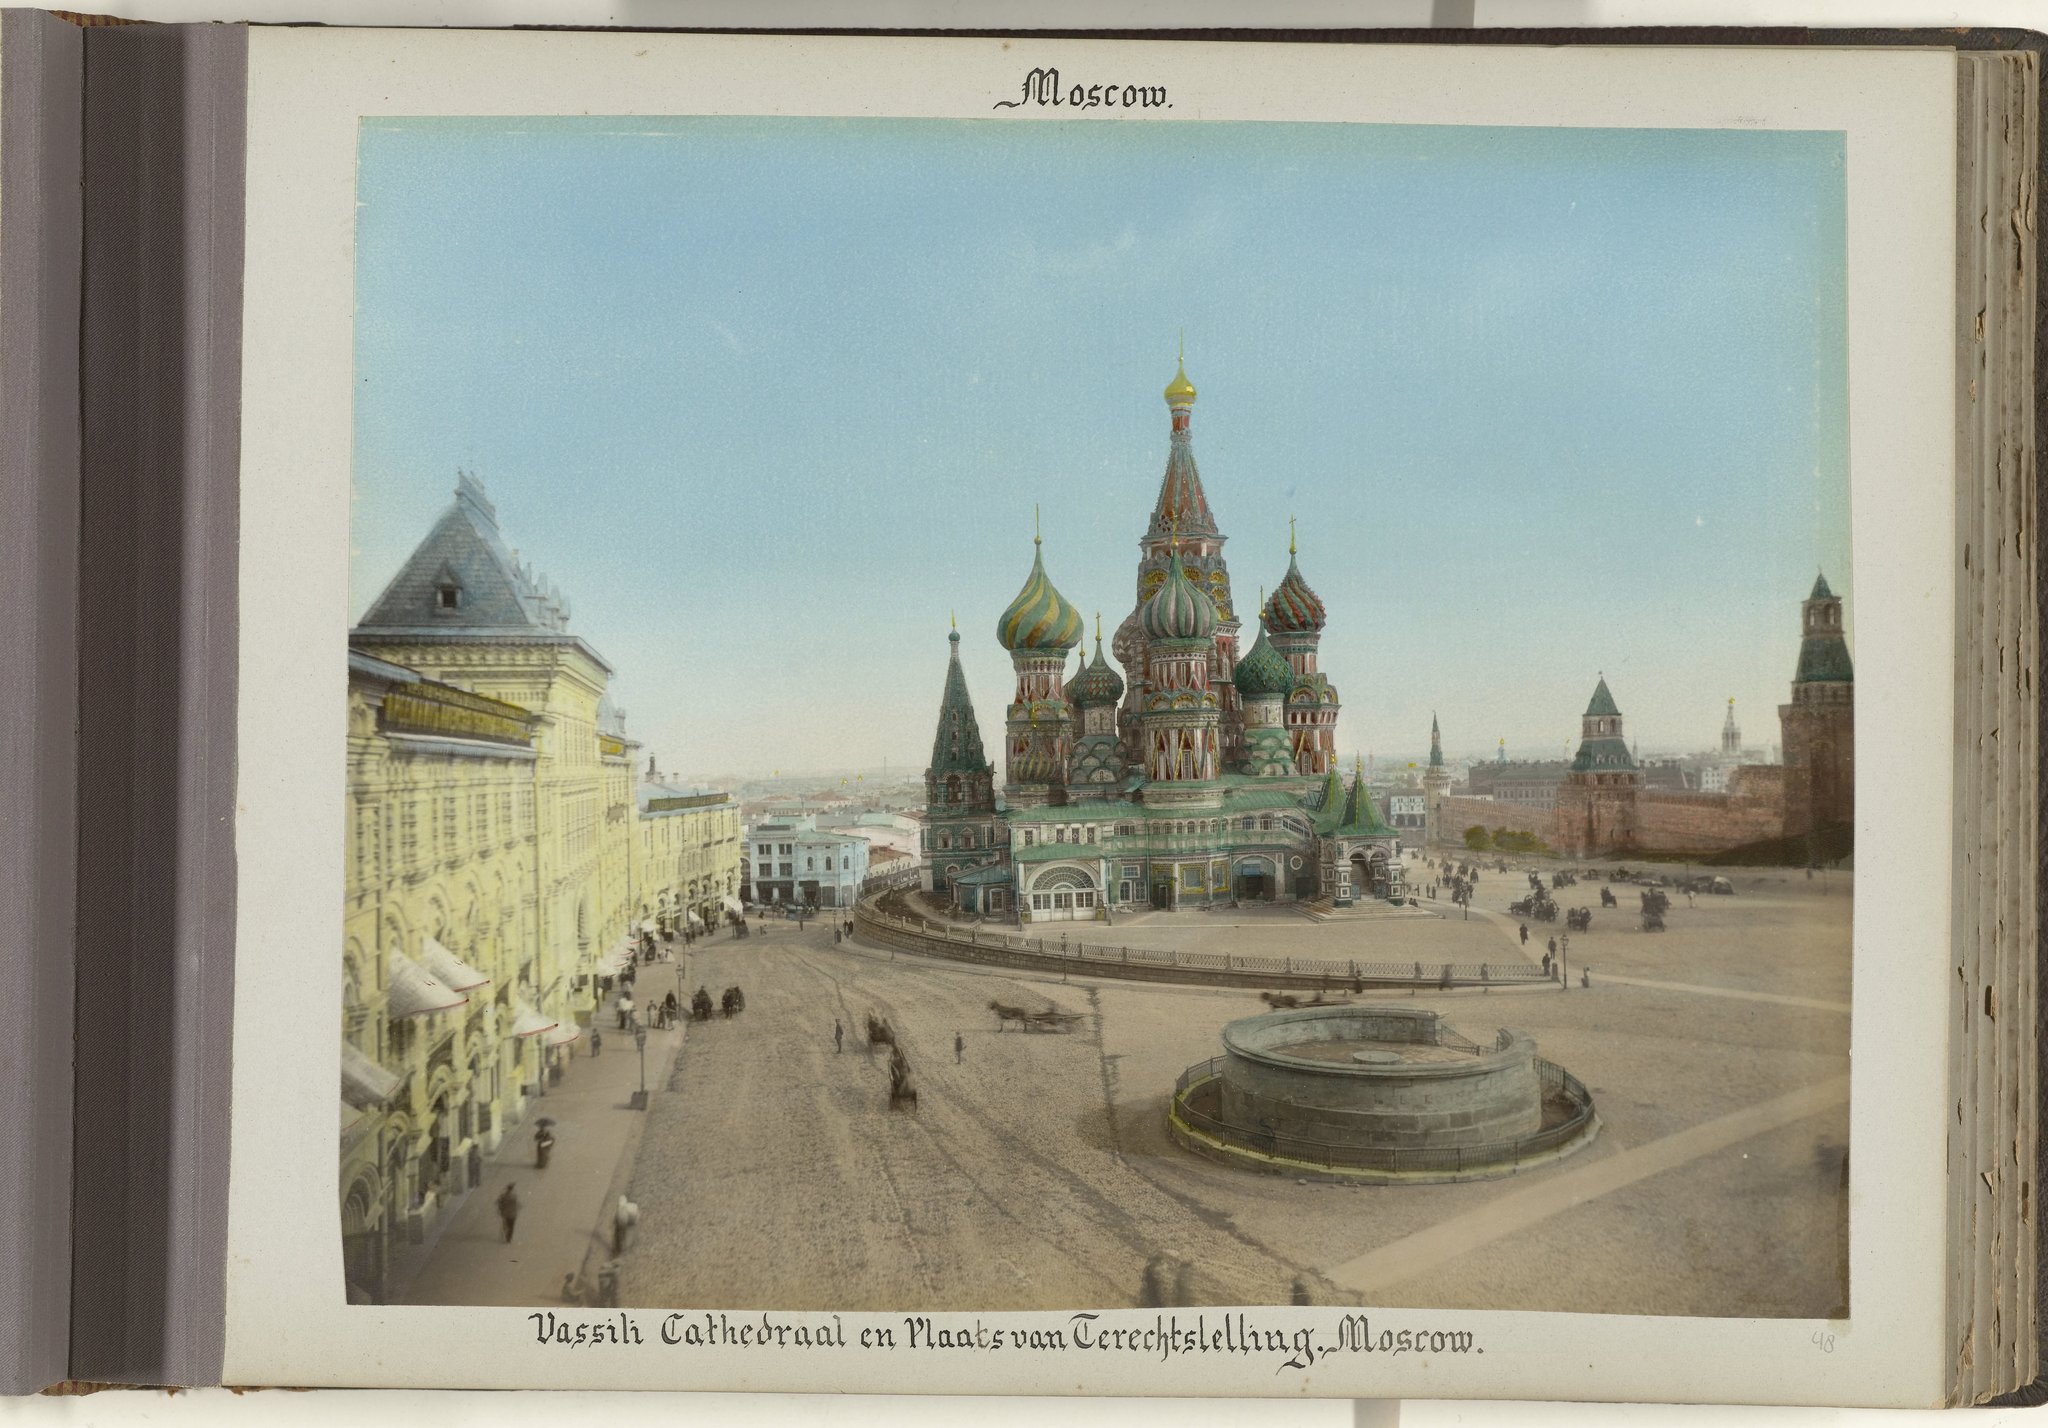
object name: photograph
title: Vassili Cathedraal en plaats van Terechtstelling Moscow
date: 1898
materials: paper, photographic support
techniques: albumen print